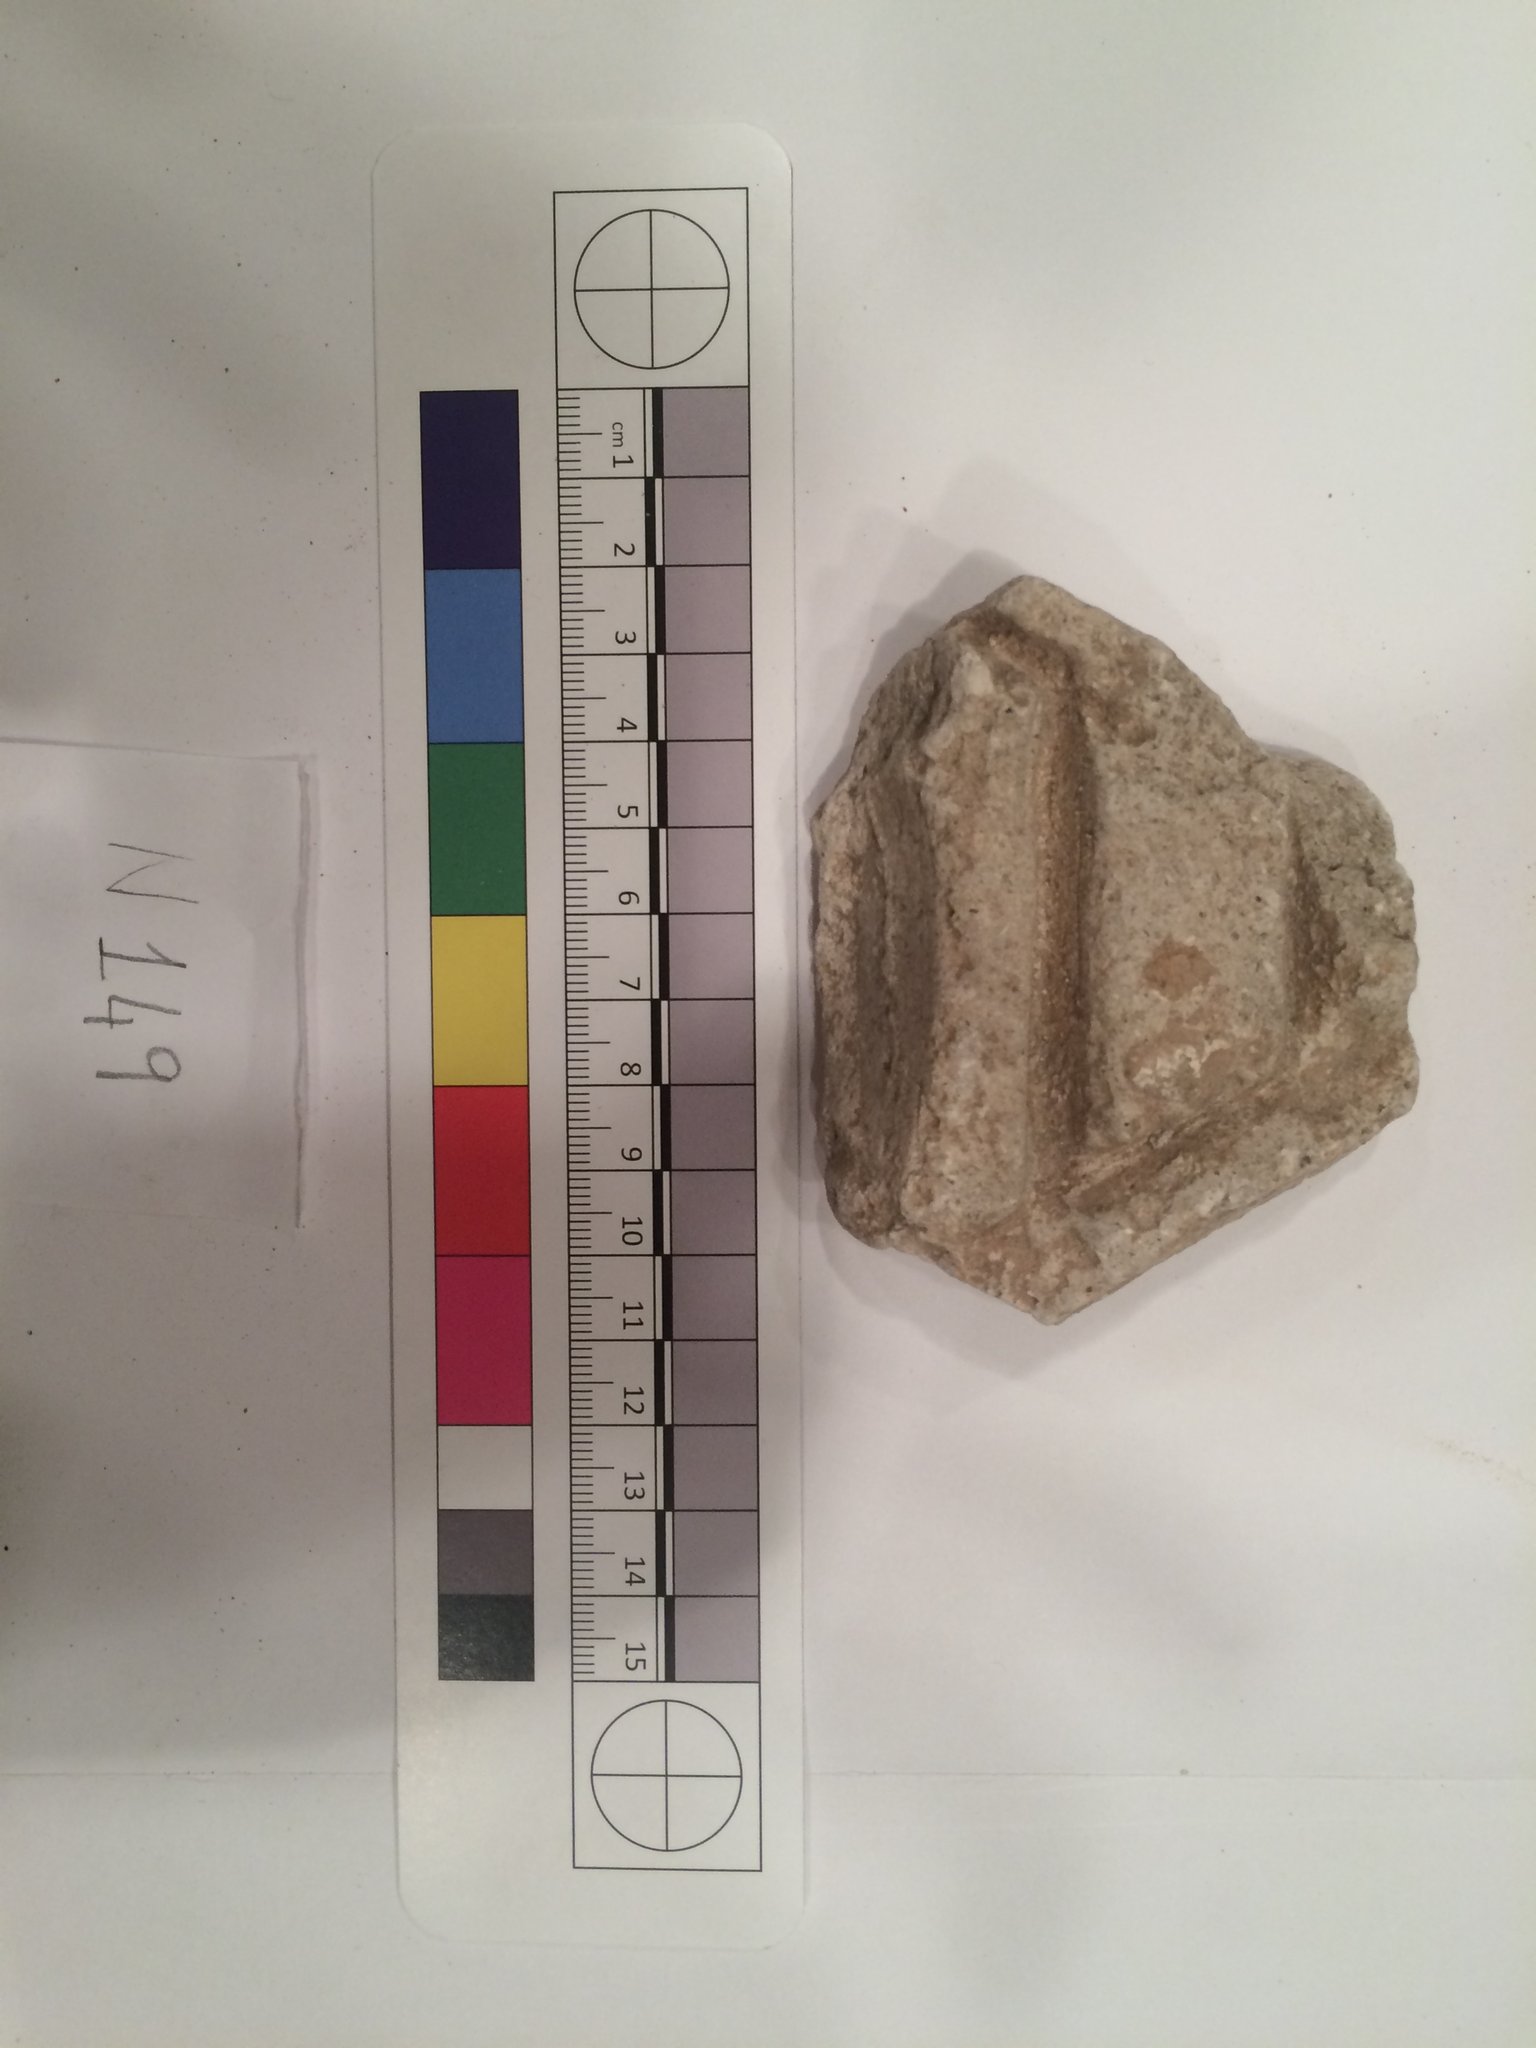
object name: fragment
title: Stucco Fragment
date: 701-1200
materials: plaster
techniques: carving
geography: iran